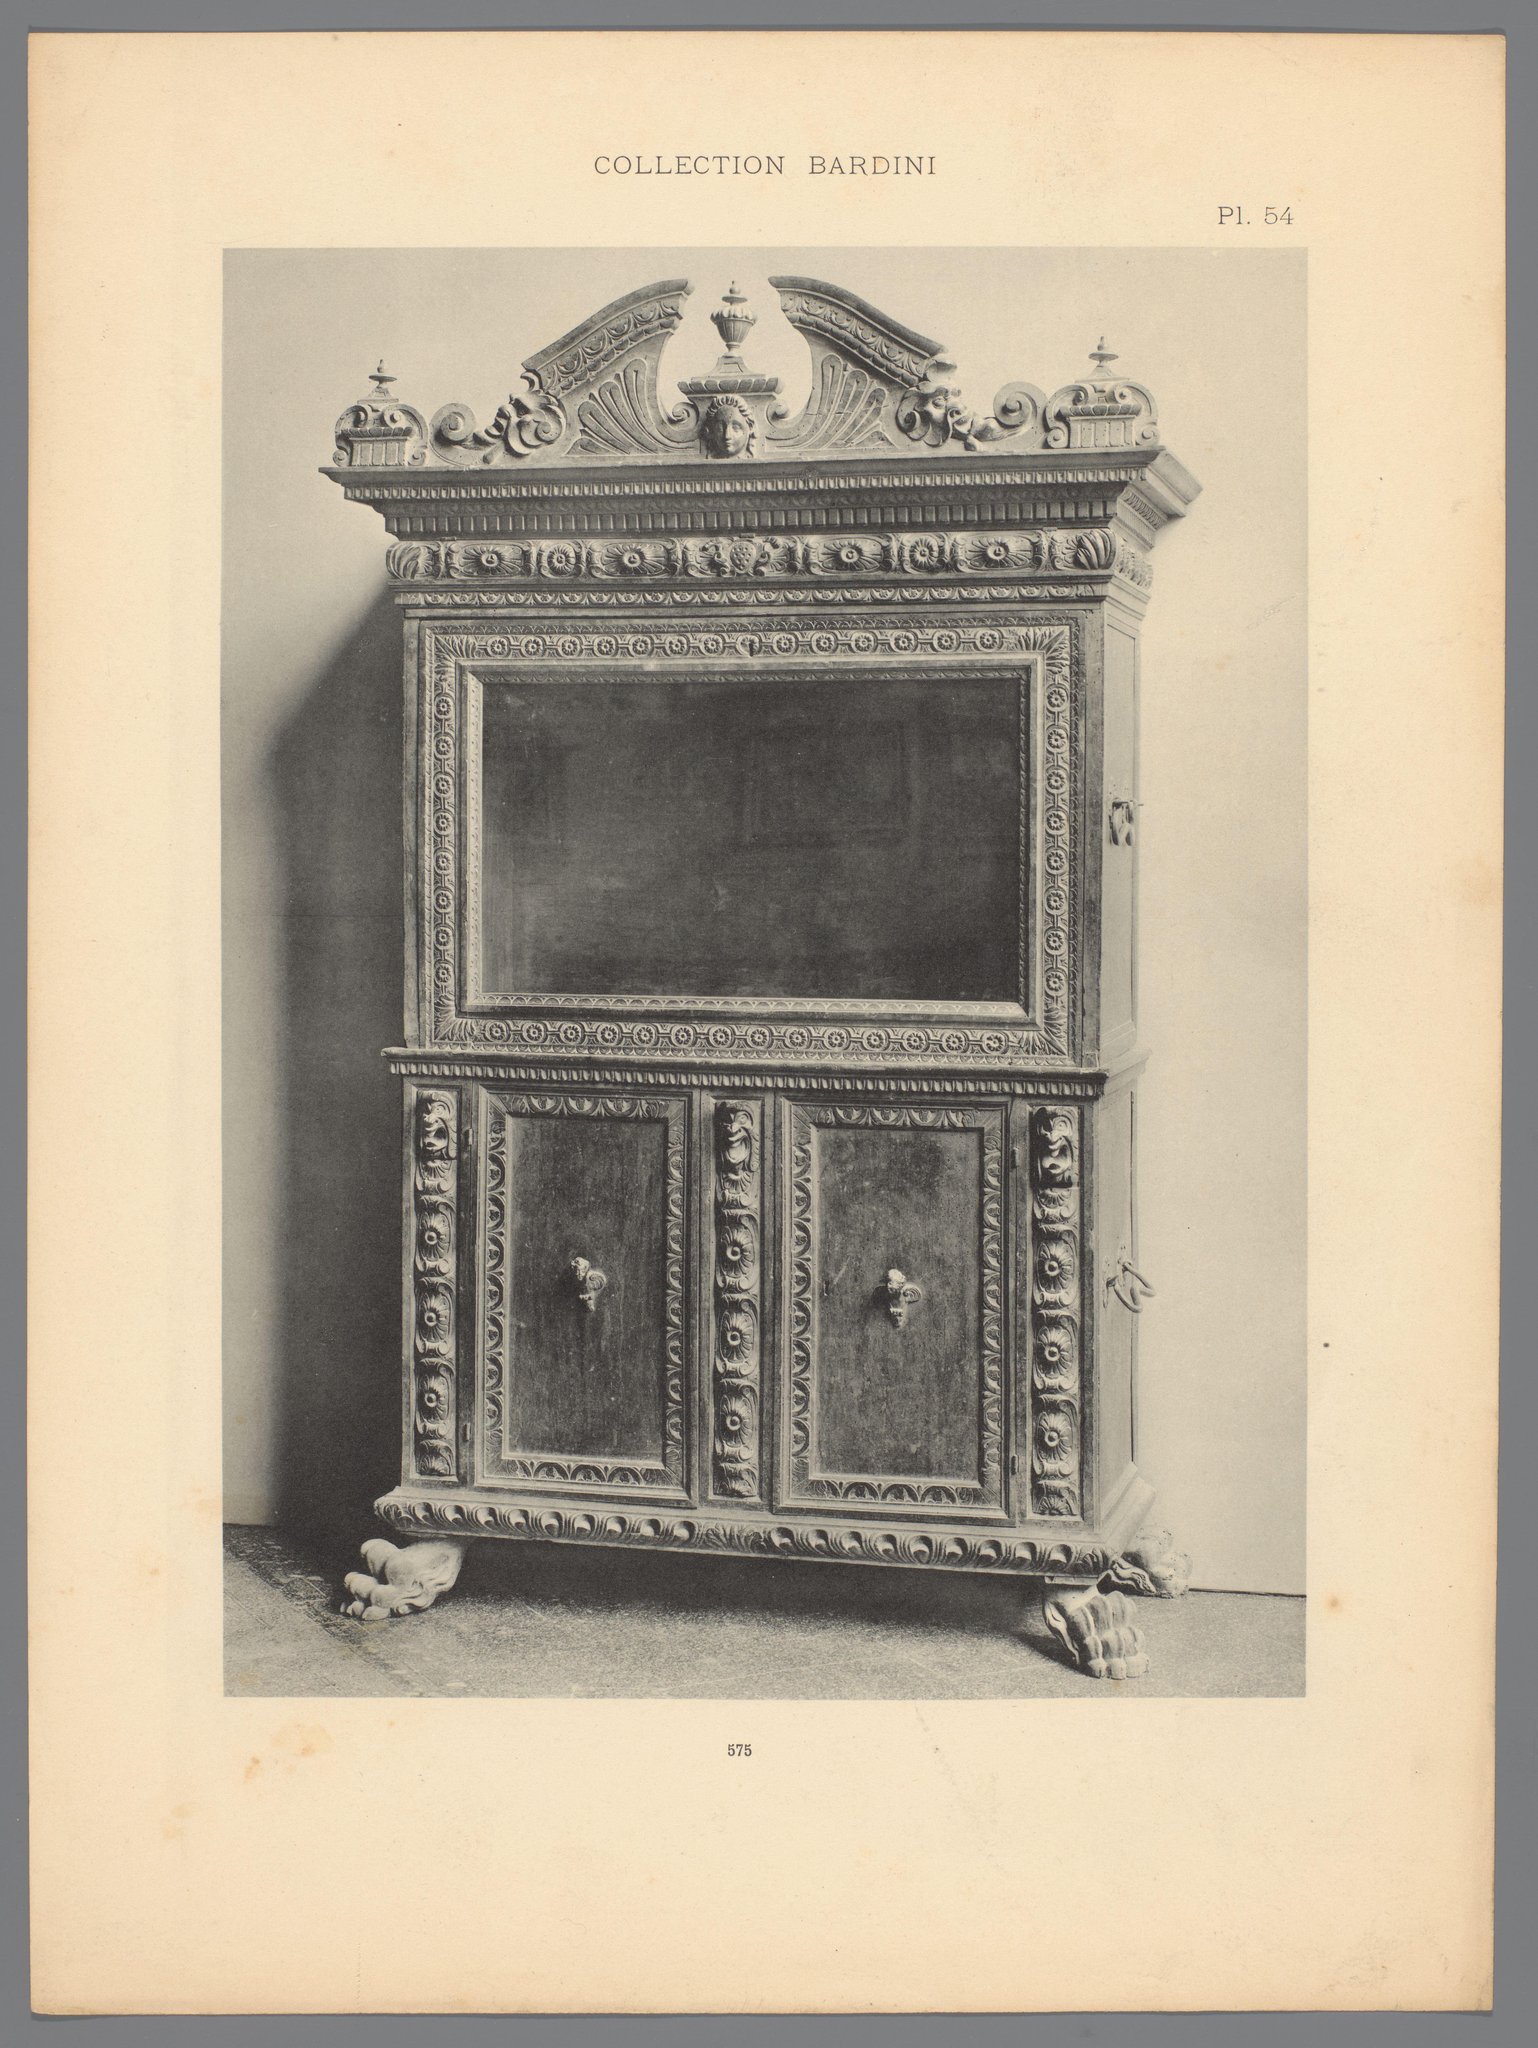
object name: photomechanical print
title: Gedecoreerd kabinet met glas in het bovenste deel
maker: Anonymous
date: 1875-1930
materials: paper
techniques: photograph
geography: florence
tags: ornamental cupboard (+ wood and other phytogenic material)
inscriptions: number: ‘Pl. 54’